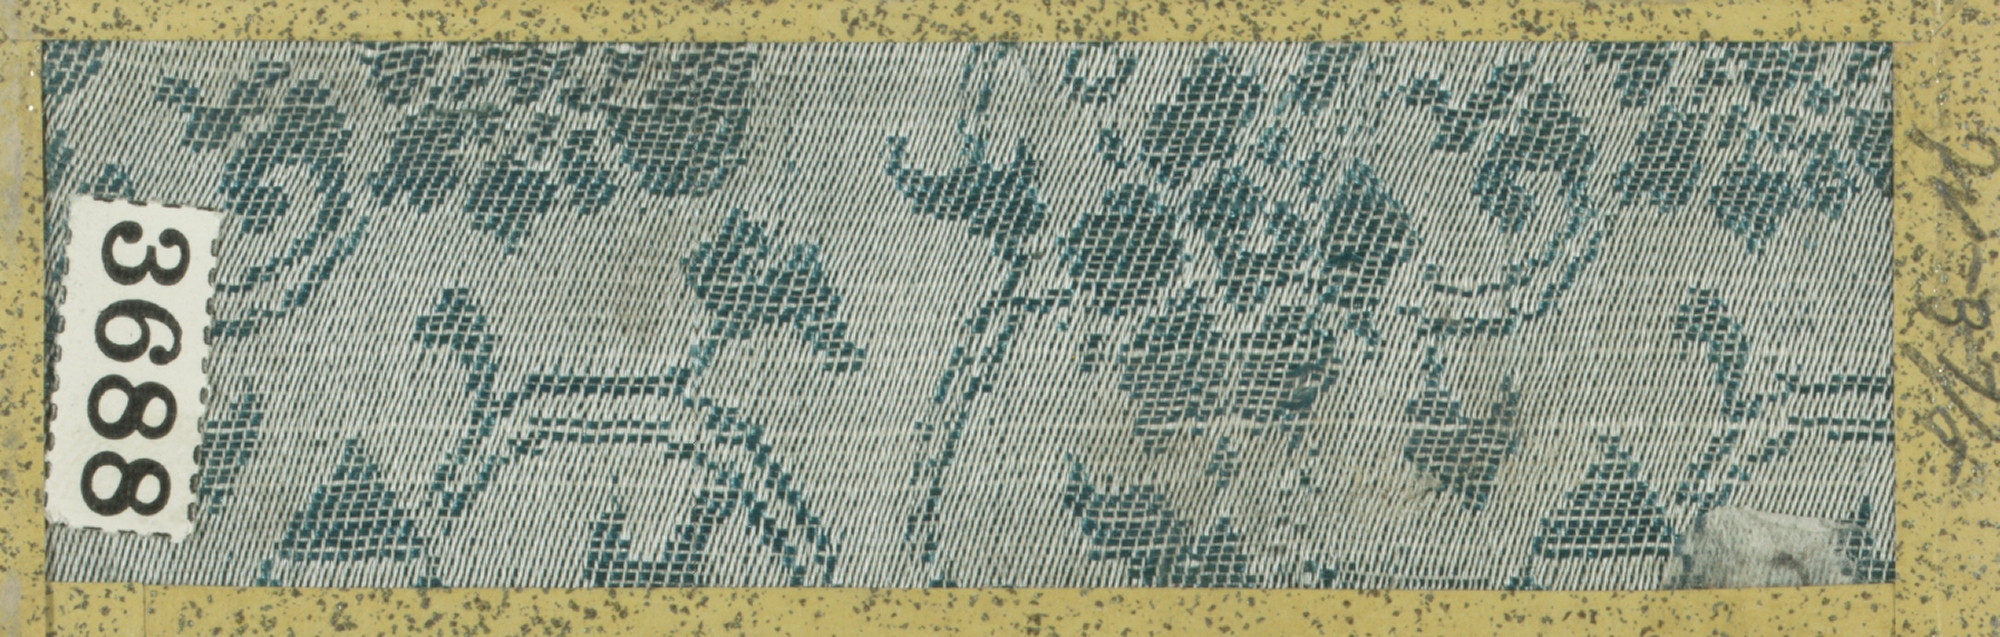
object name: sample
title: Textile Sample from Sample Book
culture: japanese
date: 1801-1900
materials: silk